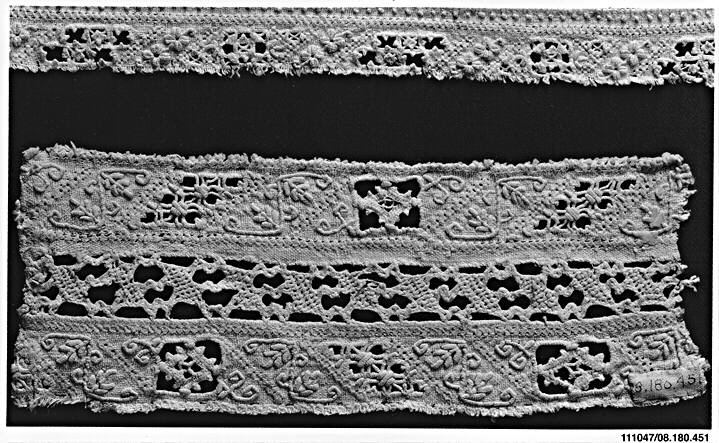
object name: piece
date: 1501-1600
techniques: embroidery